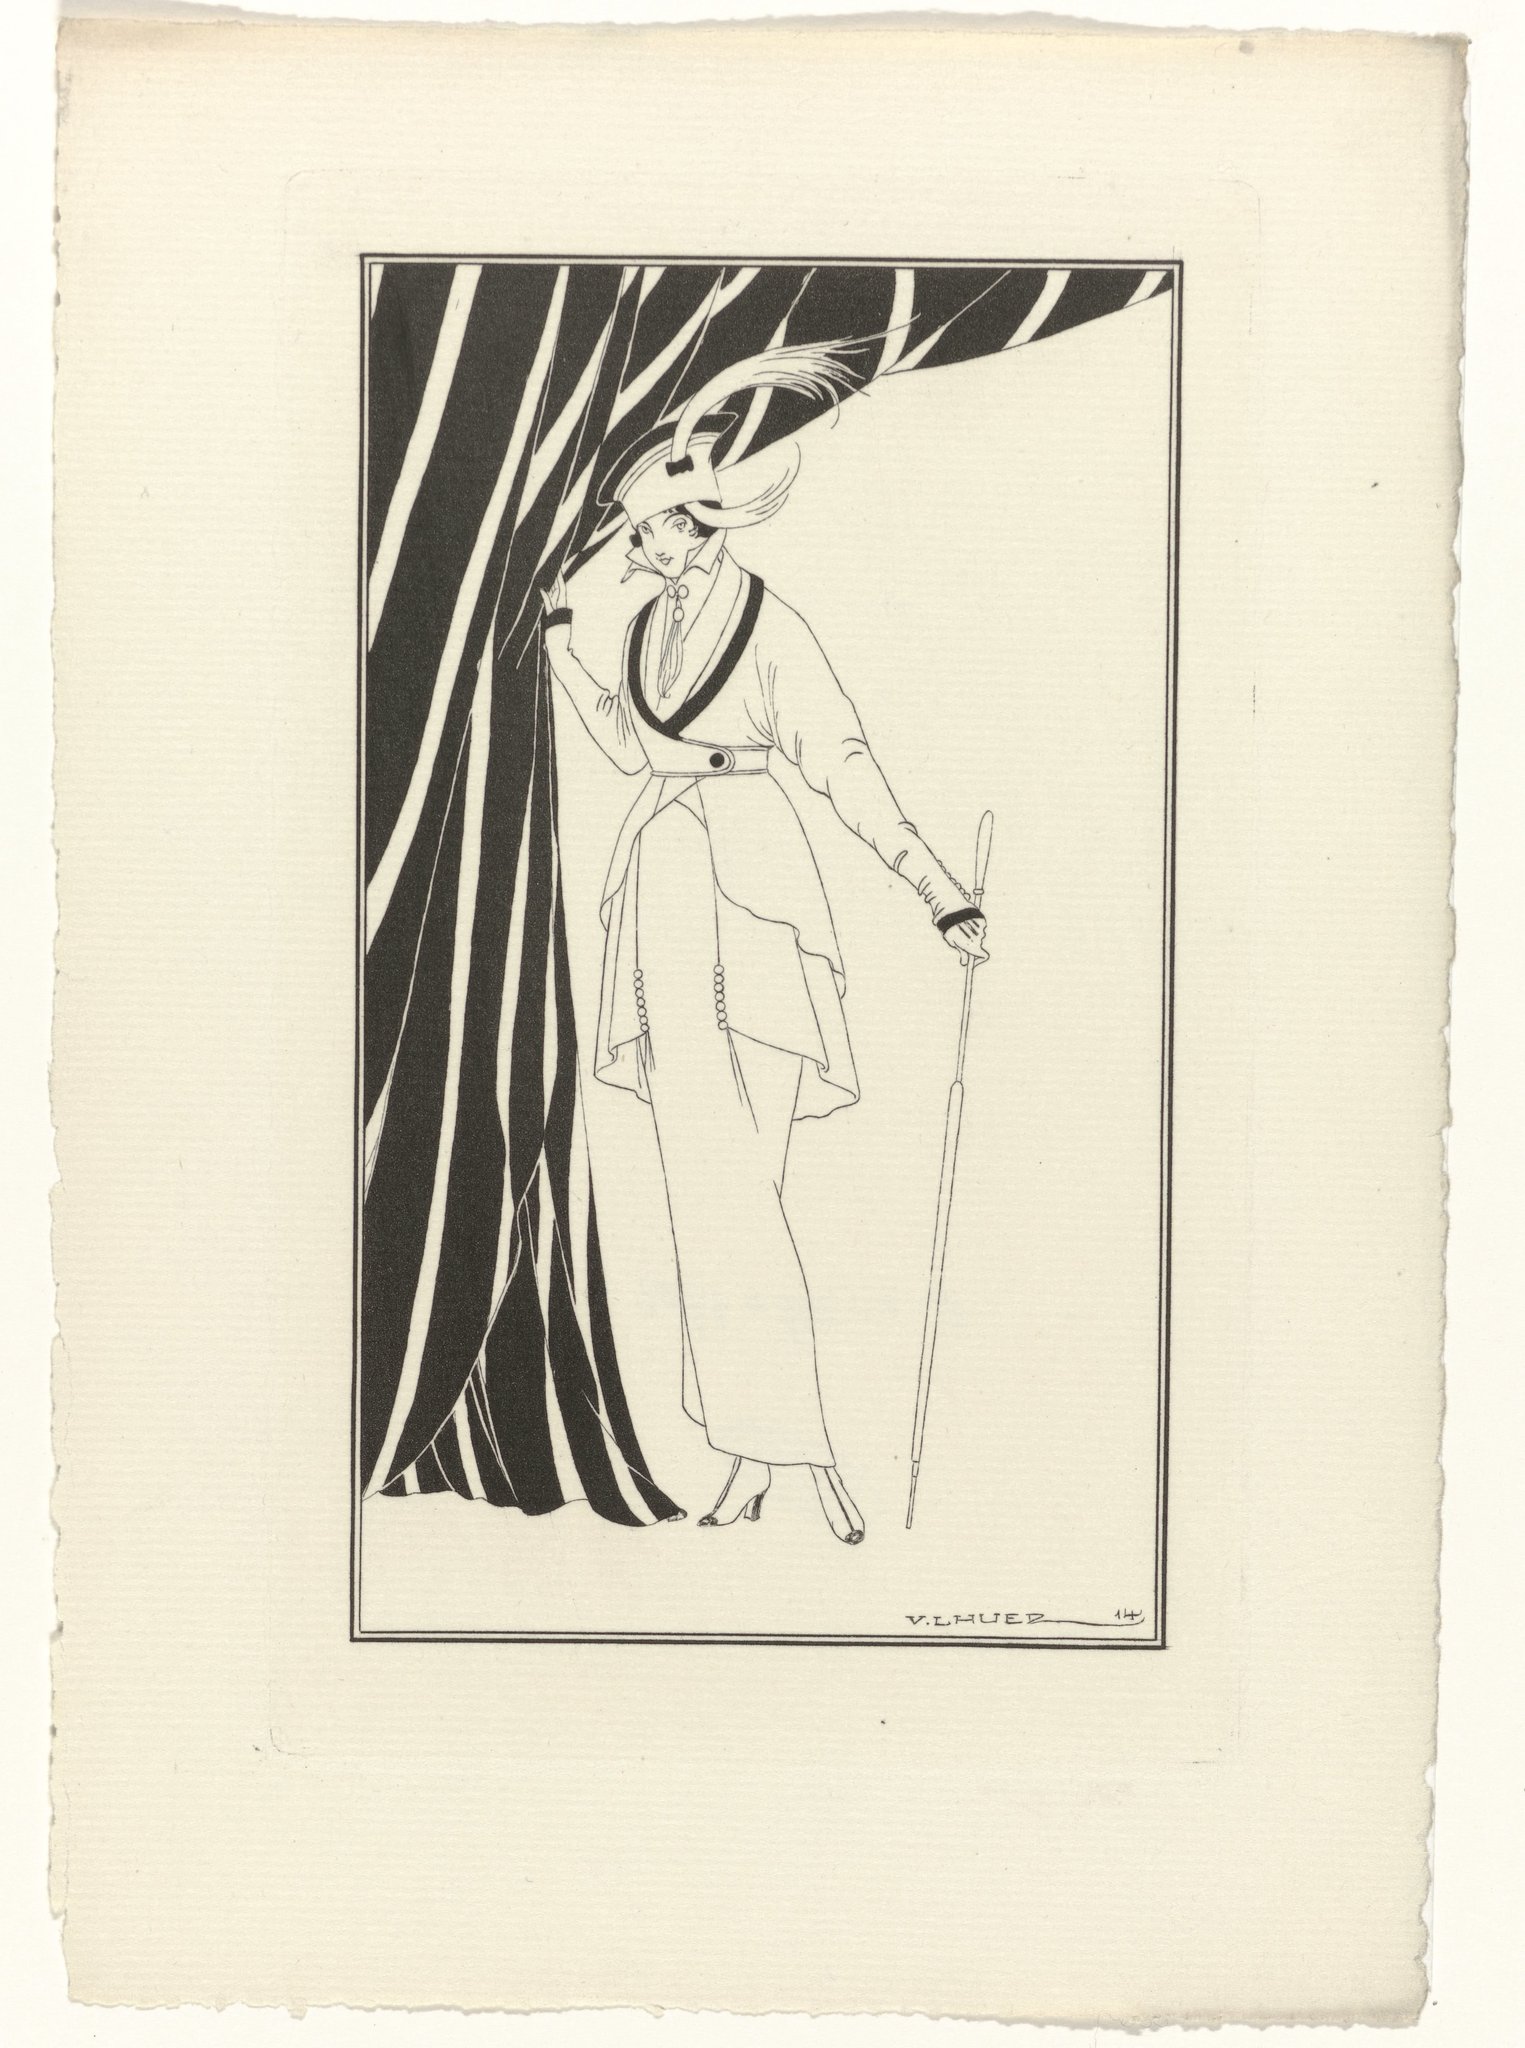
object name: fashion print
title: Journal des Dames et des Modes, Costumes Parisiens, 1914, No. 153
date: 1914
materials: paper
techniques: engraving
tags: curtains, clothing for the upper part of the body (+ women's clothes), walking-stick, staff, cane (+ women's clothes), ensembles of pieces of clothing (suit) (+ women's clothes), coat (+ women's clothes), head-gear (+ women's clothes), fashion plates, skirt (+ women's clothes)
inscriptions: date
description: Mantelpak van kanariegeel laken, versierd met knopen van licht barnsteen. Proefdruk van een prent uit het modetijdschrift Journal des Dames et des Modes (1912-1914).